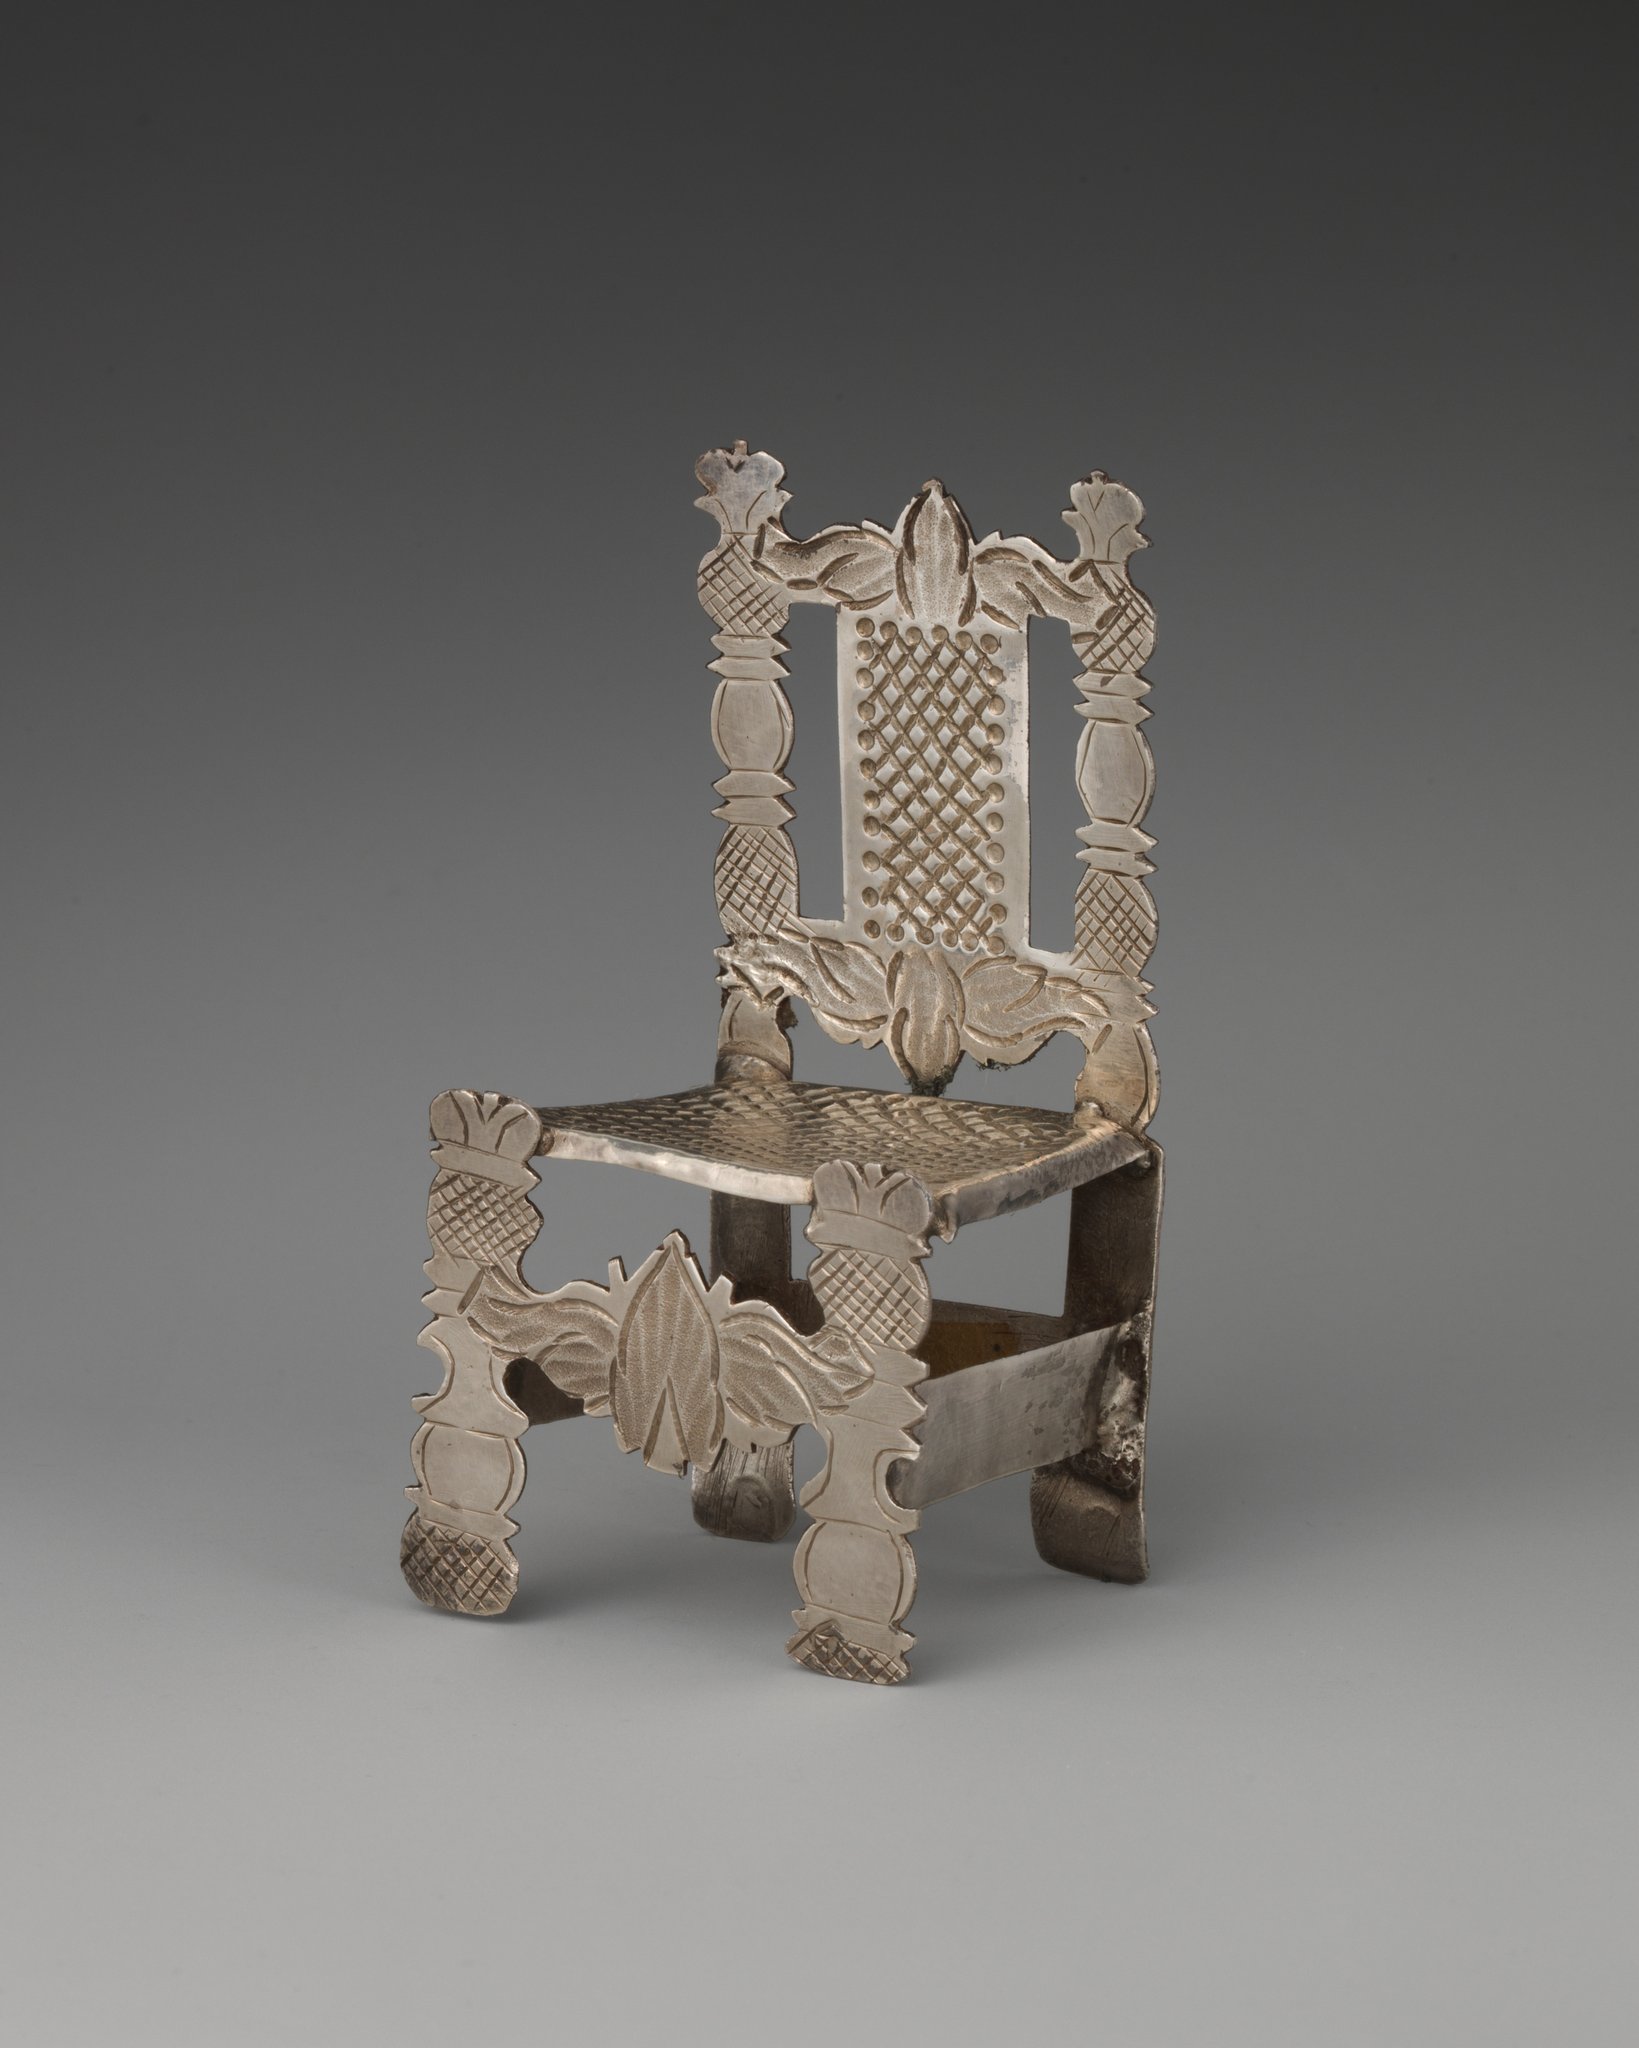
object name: chair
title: Miniature chair (one of four) (part of a set)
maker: george manjoy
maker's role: maker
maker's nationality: british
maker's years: 1685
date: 1690-1691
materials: silver